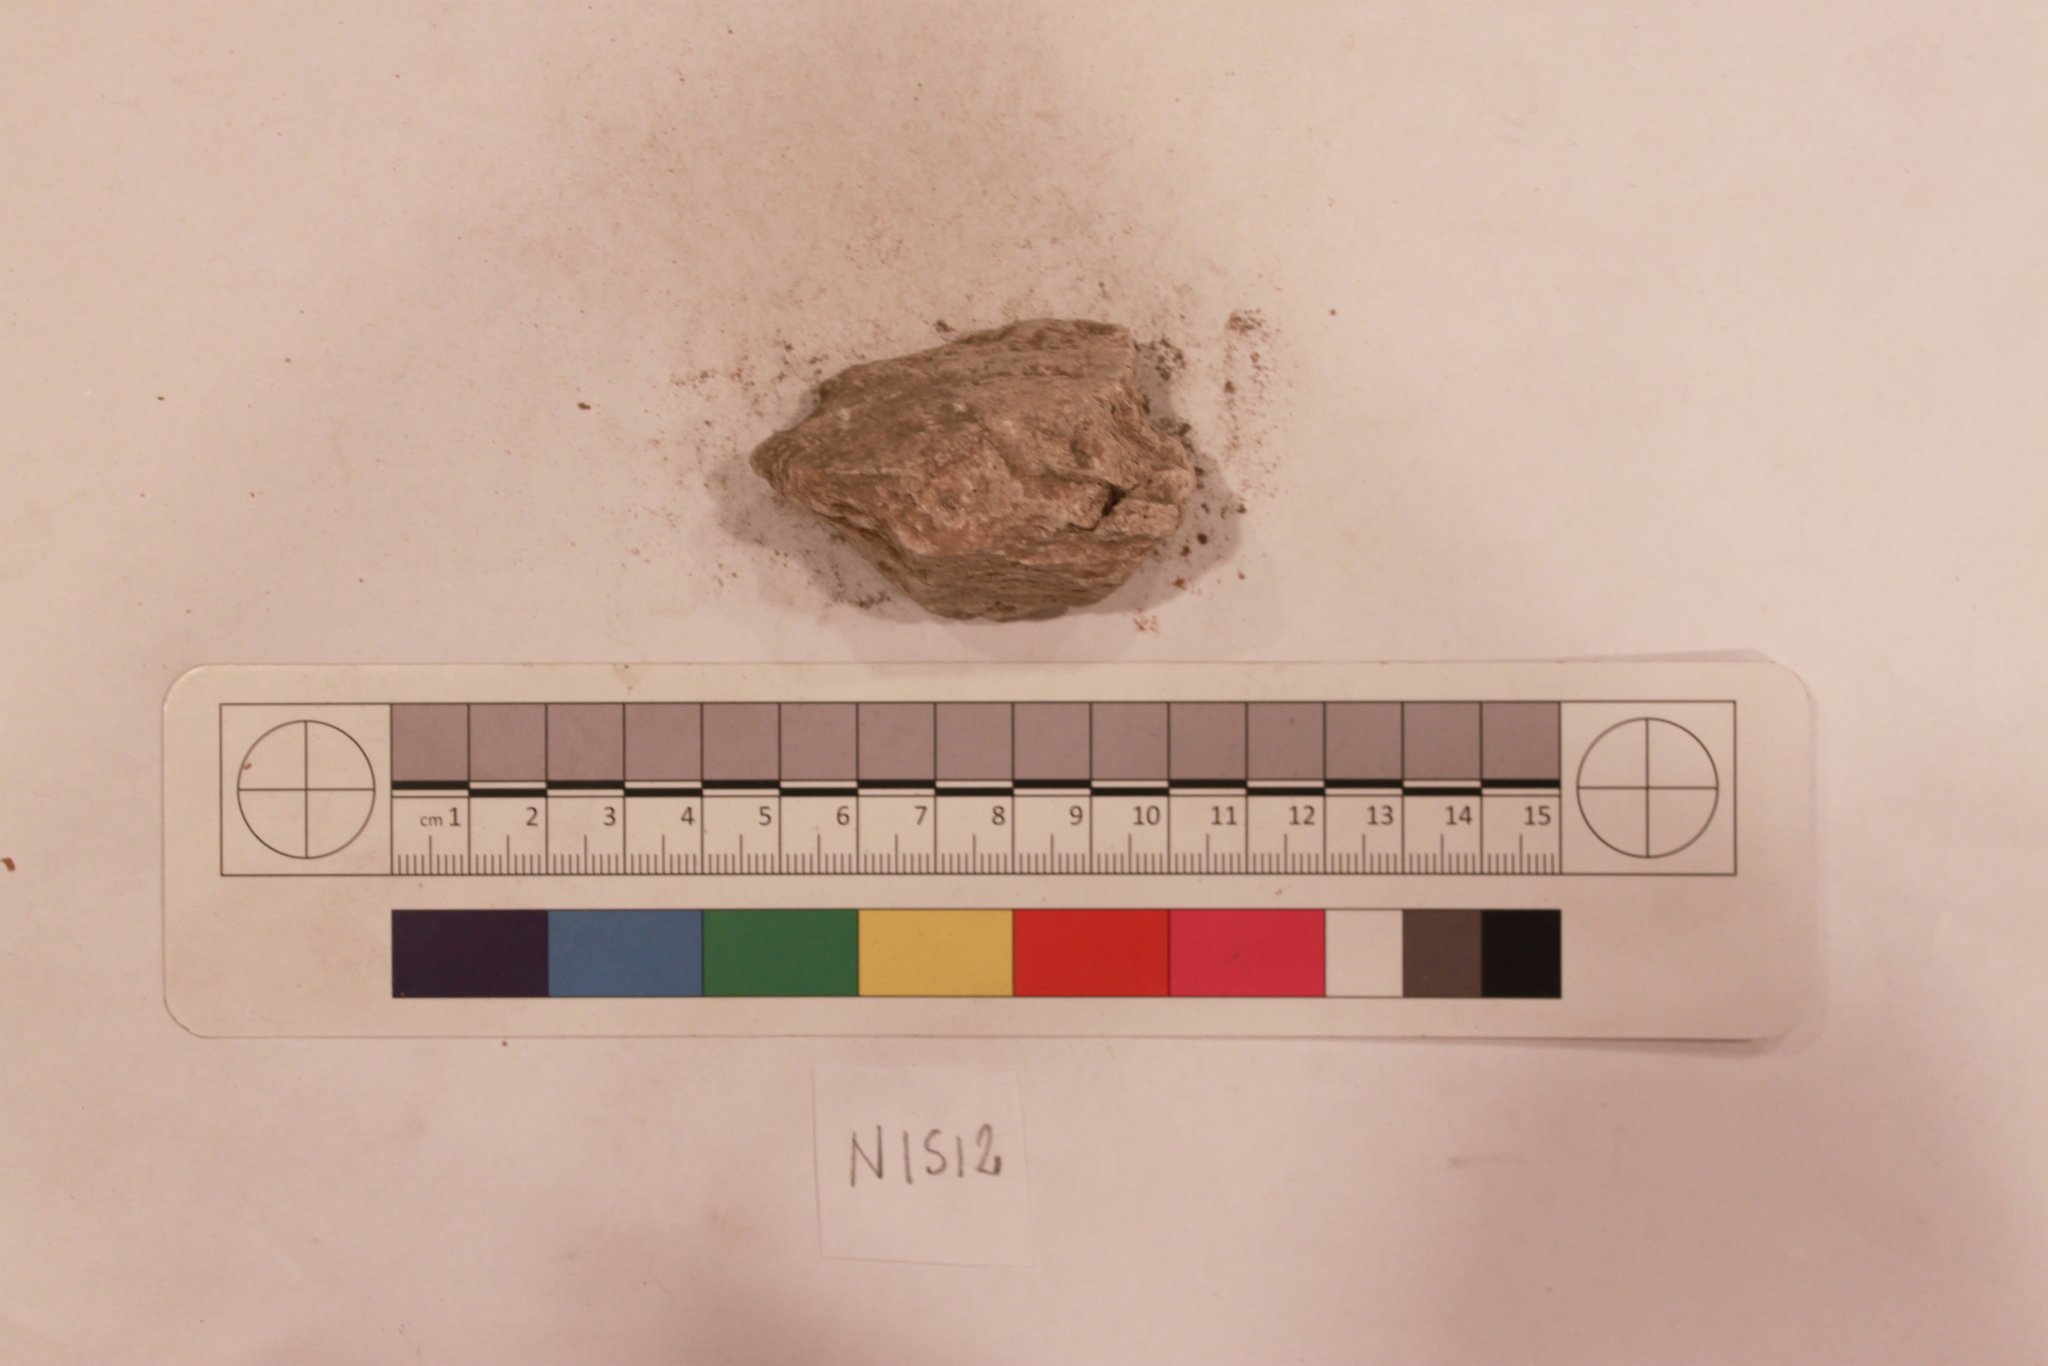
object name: fragment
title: Stucco Fragment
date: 701-1200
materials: plaster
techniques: carving, painting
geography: iran